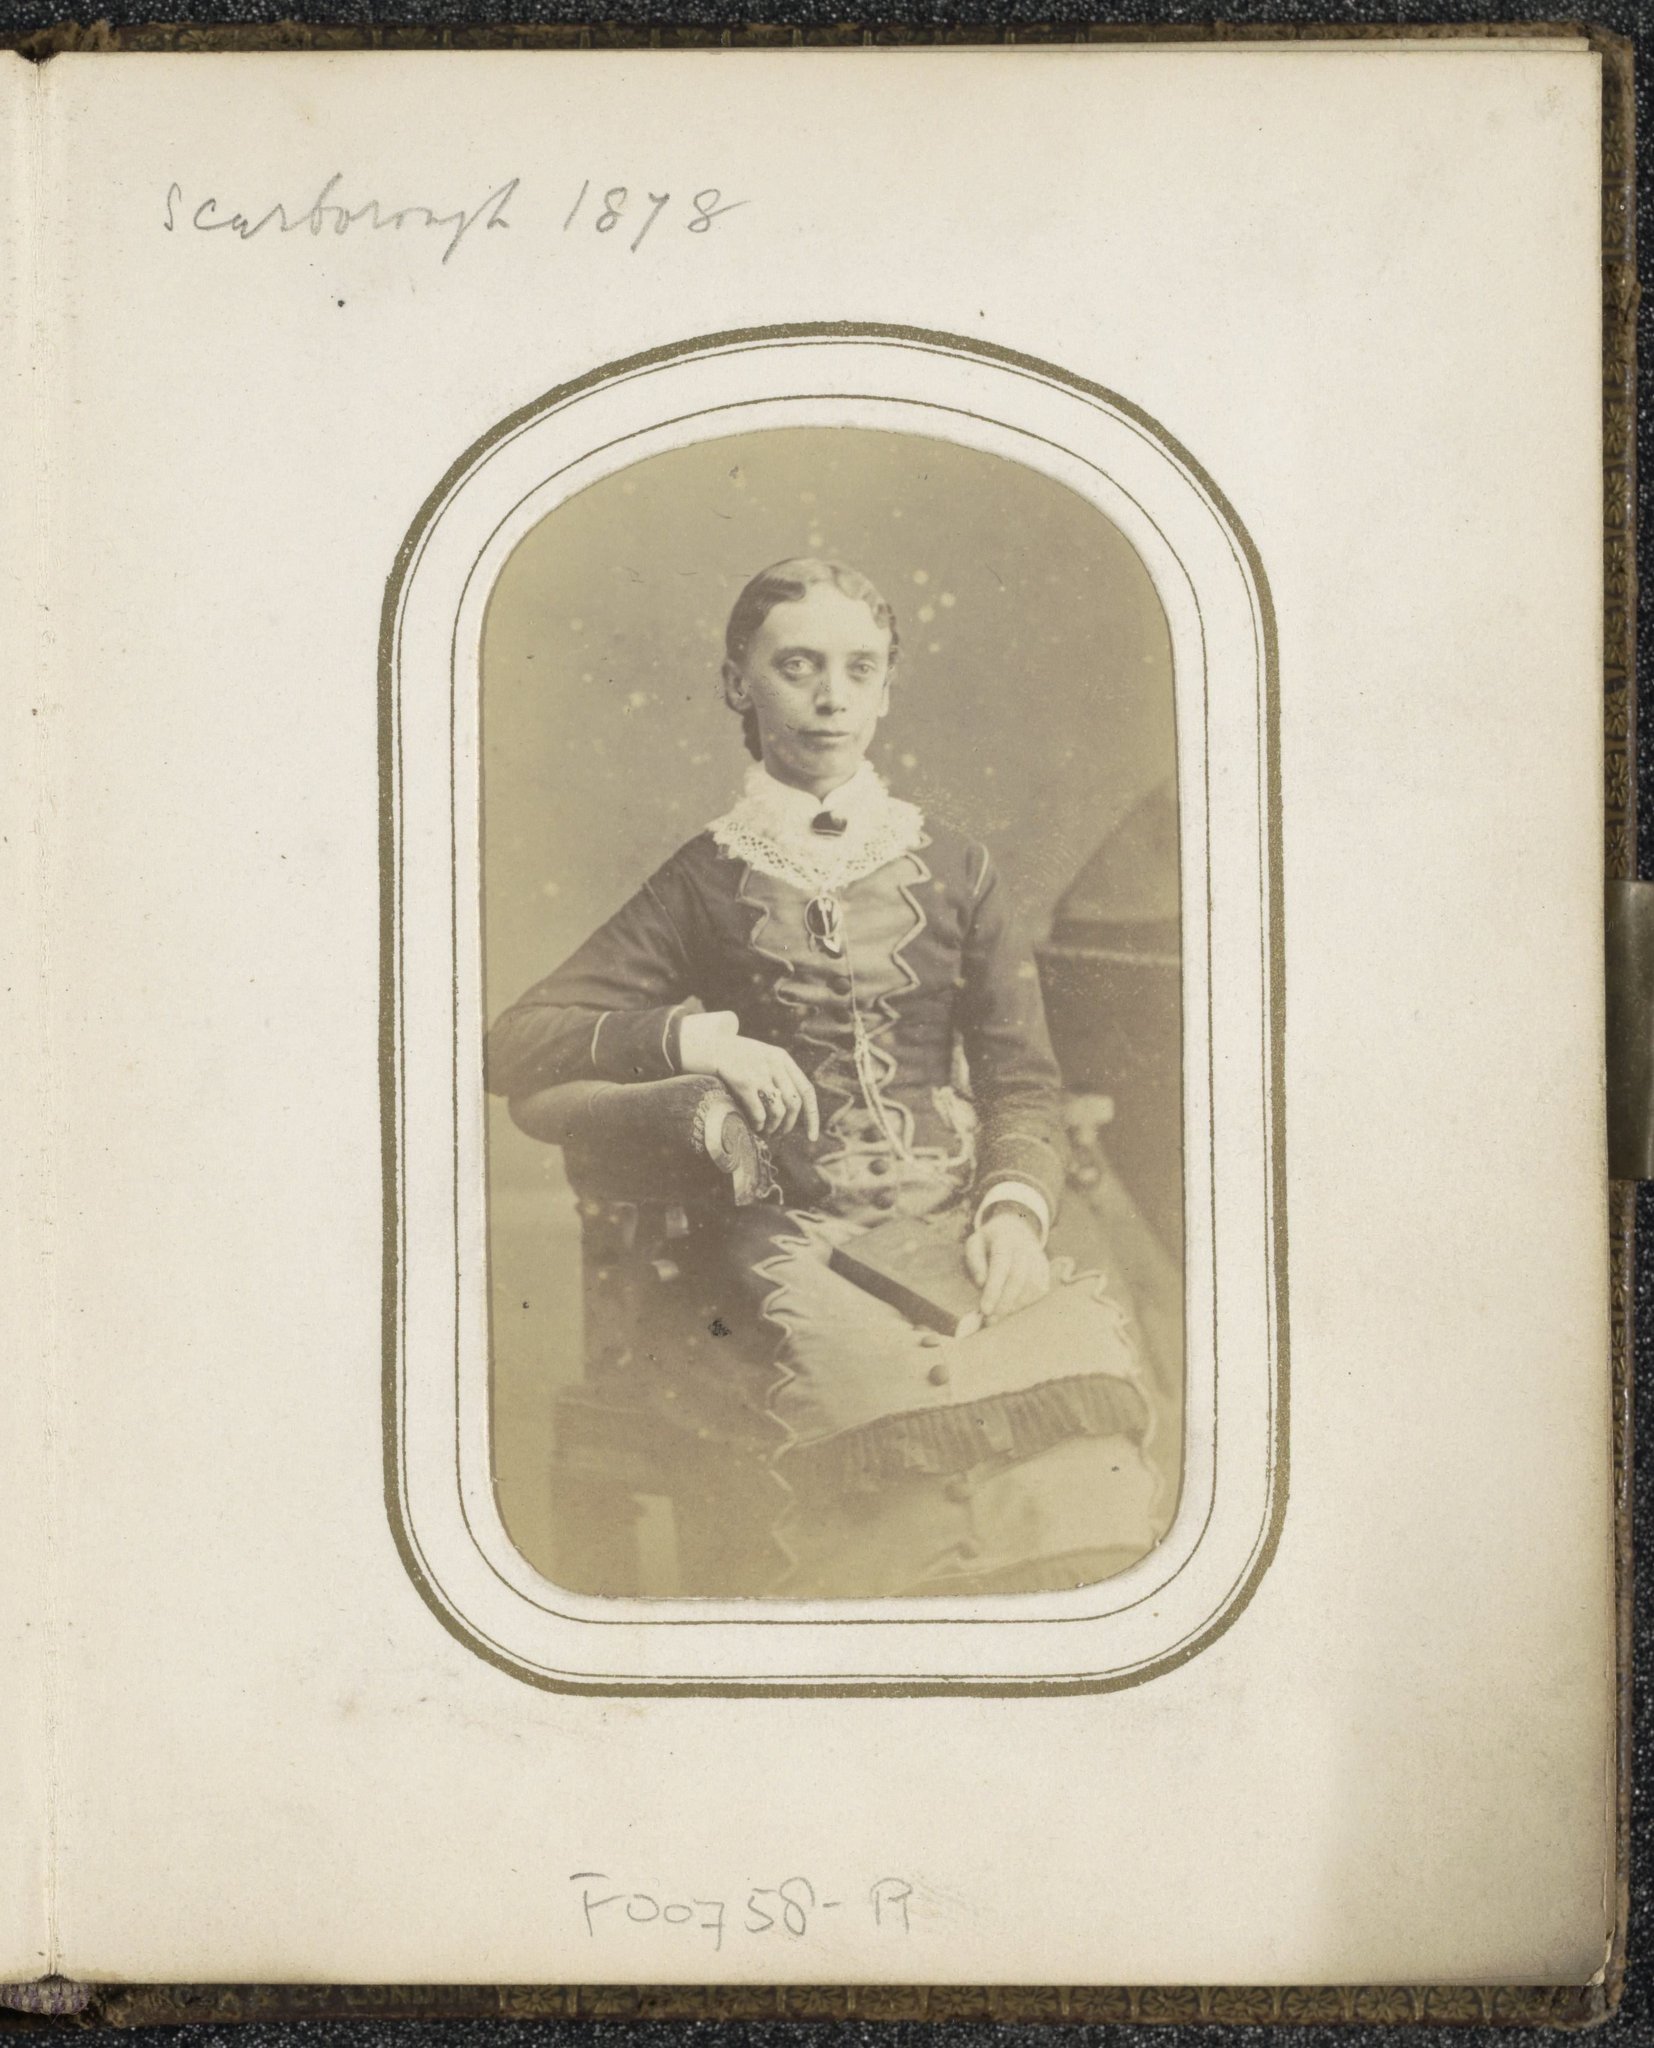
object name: photograph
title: Portret van een vrouw met een boek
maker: john inskip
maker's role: fotograaf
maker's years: 1833-1909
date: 1878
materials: cardboard, paper, photographic support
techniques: albumen print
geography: scarborough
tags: studio requisites ~ photographer, historical persons, book, dress, gown, neck-gear: collar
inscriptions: address: ‘Scarboro, The Cliff’, inscription: ‘Scarborough 1878’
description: Onderdeel van Engels fotoalbum van E.A. Kettle met 42 cartes-de-visite.